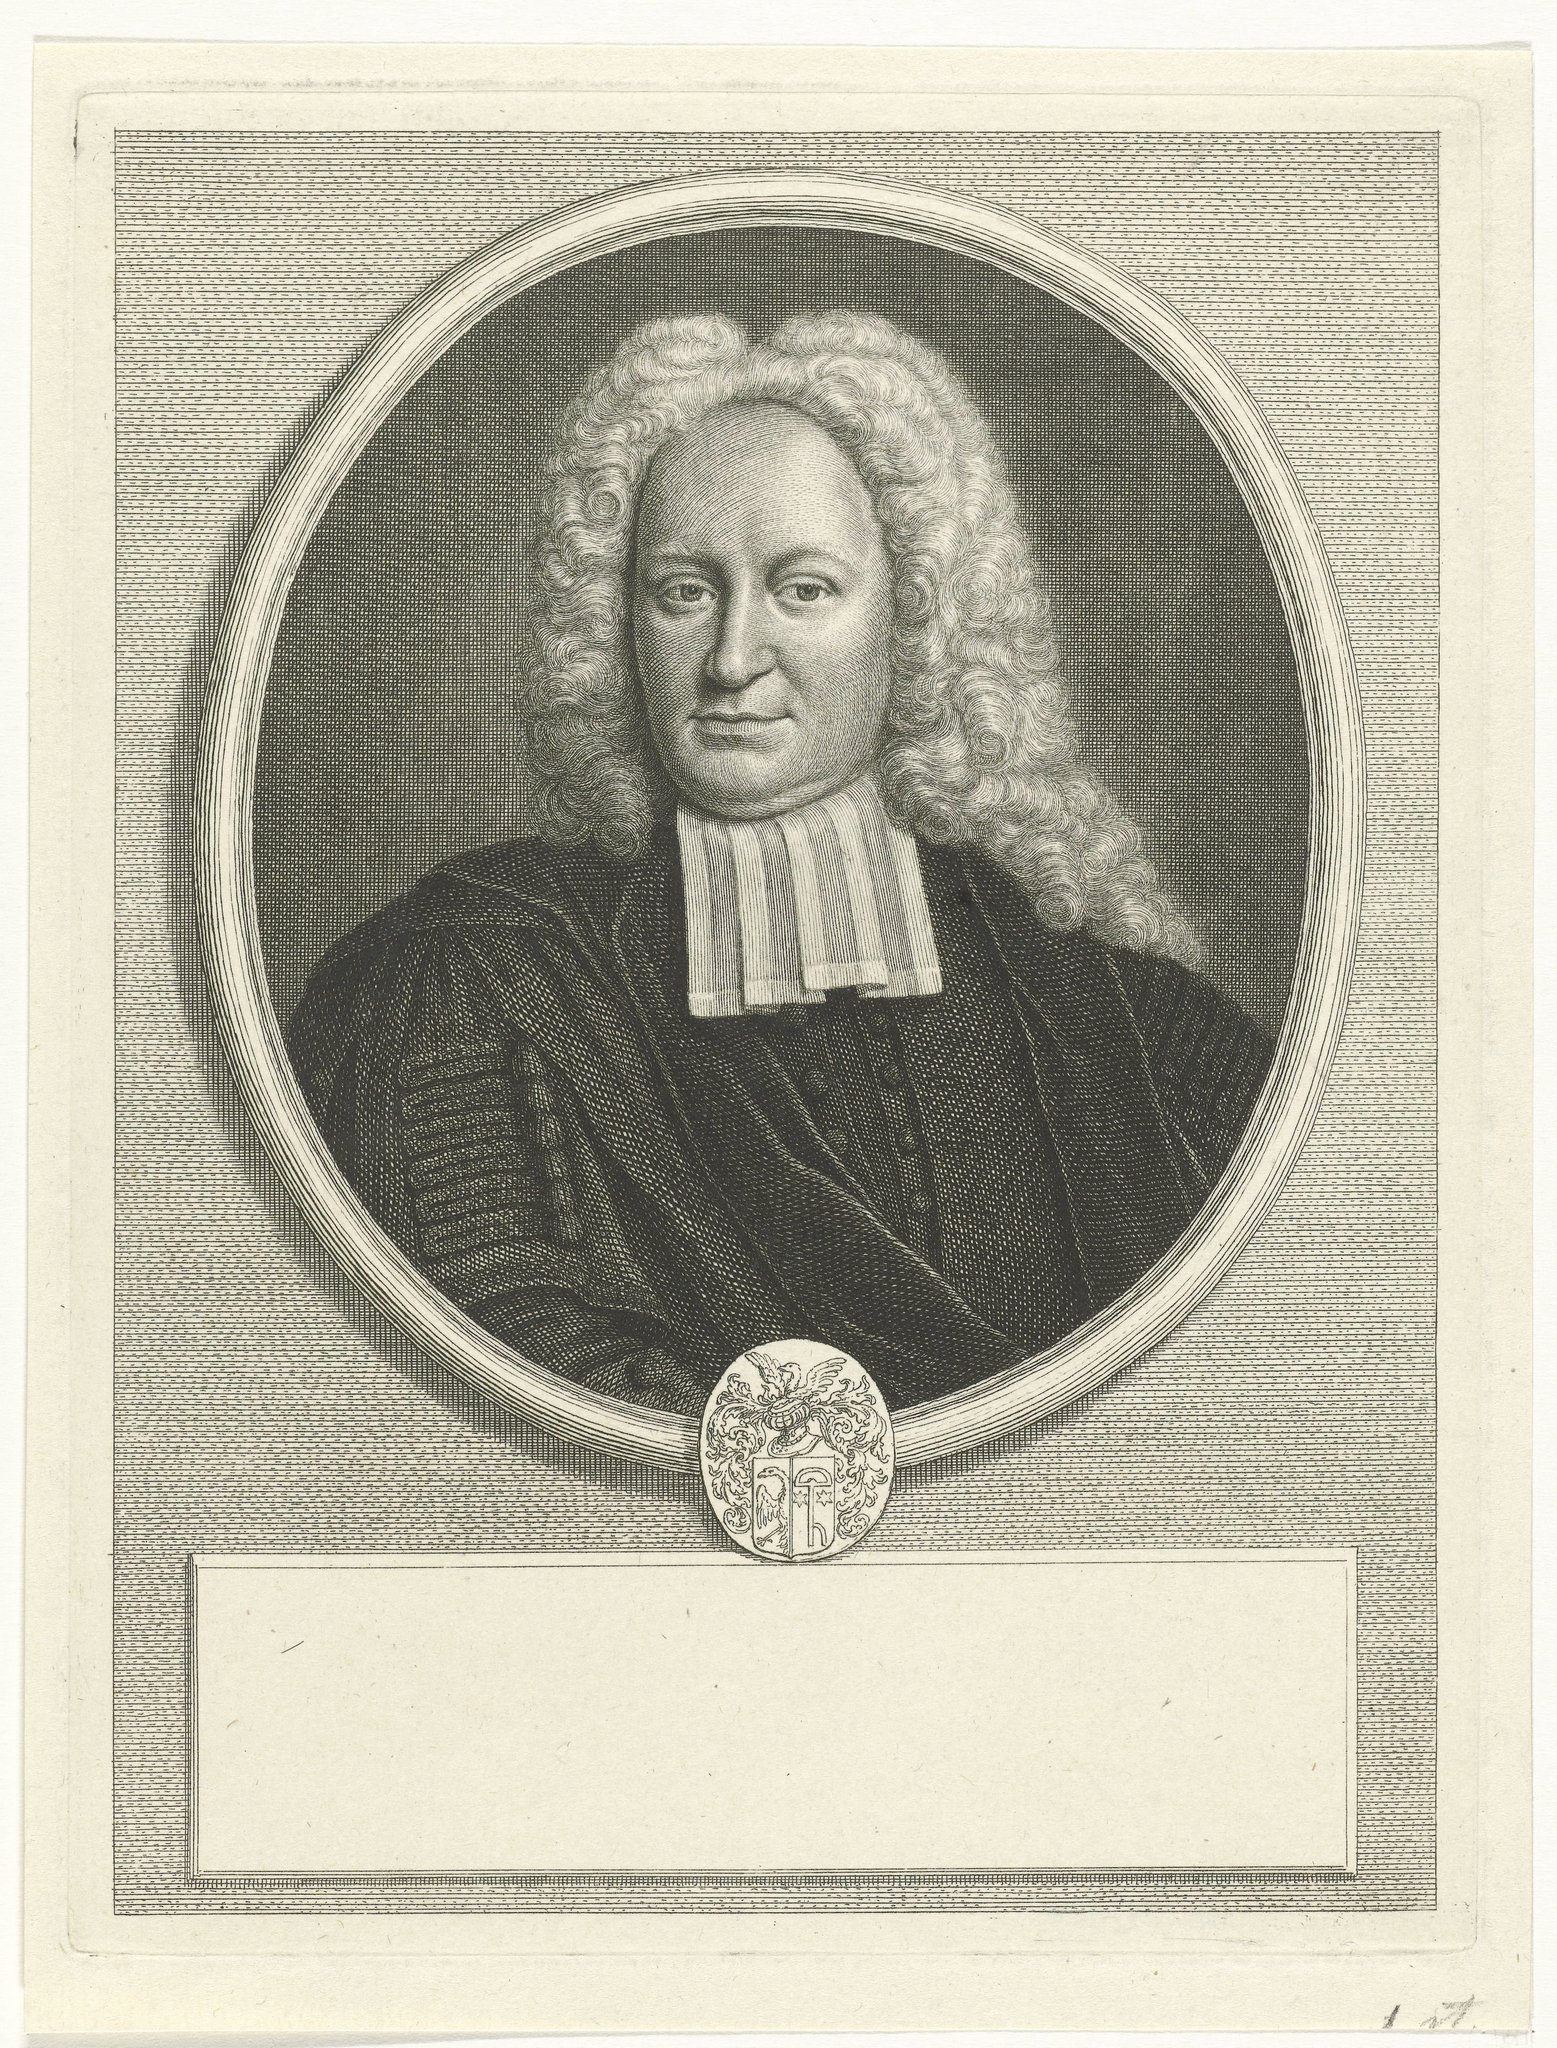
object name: print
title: Portret van Johannes Ens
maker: jacob folkema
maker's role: draughtsman, print maker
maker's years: 1692-1767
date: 1712-1767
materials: paper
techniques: engraving, etching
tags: utrecht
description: Portretbuste in ovaal naar rechts van hoogleraar en predikant Johannes Ens, blootshoofds en gehuld in een toga. Onderin de ovale lijst prijkt zijn wapenschild.